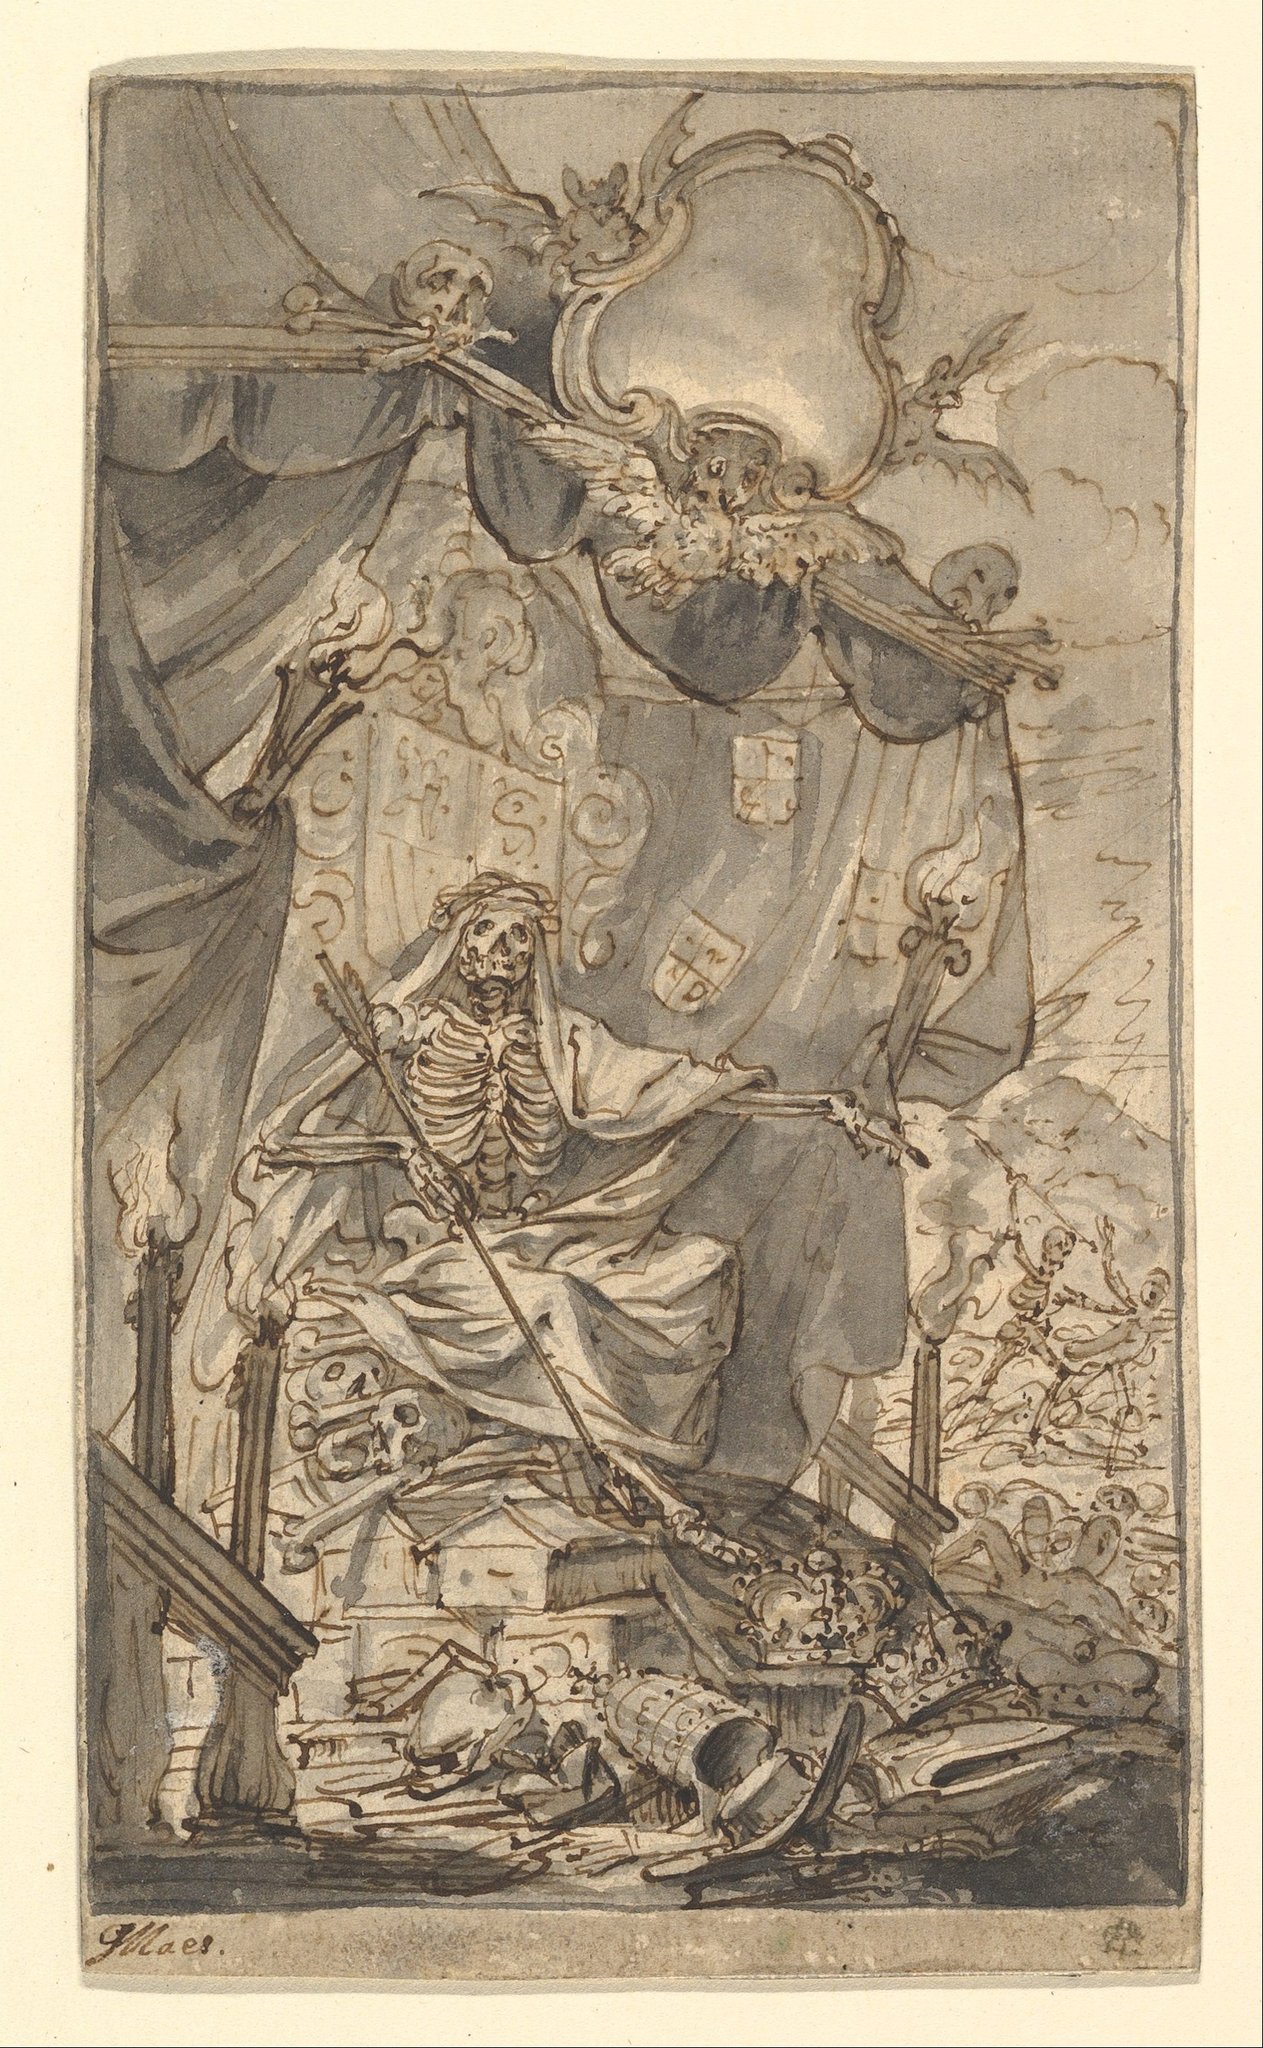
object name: drawing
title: Death on a Canopied Throne (Design for a Title Page)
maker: godfried maes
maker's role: artist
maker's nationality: flemish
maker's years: 1649-1700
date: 1667-1700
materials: chalk, gouache, ink, paper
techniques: brush, incising, pen, wash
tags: houses,skeletons,skulls,death